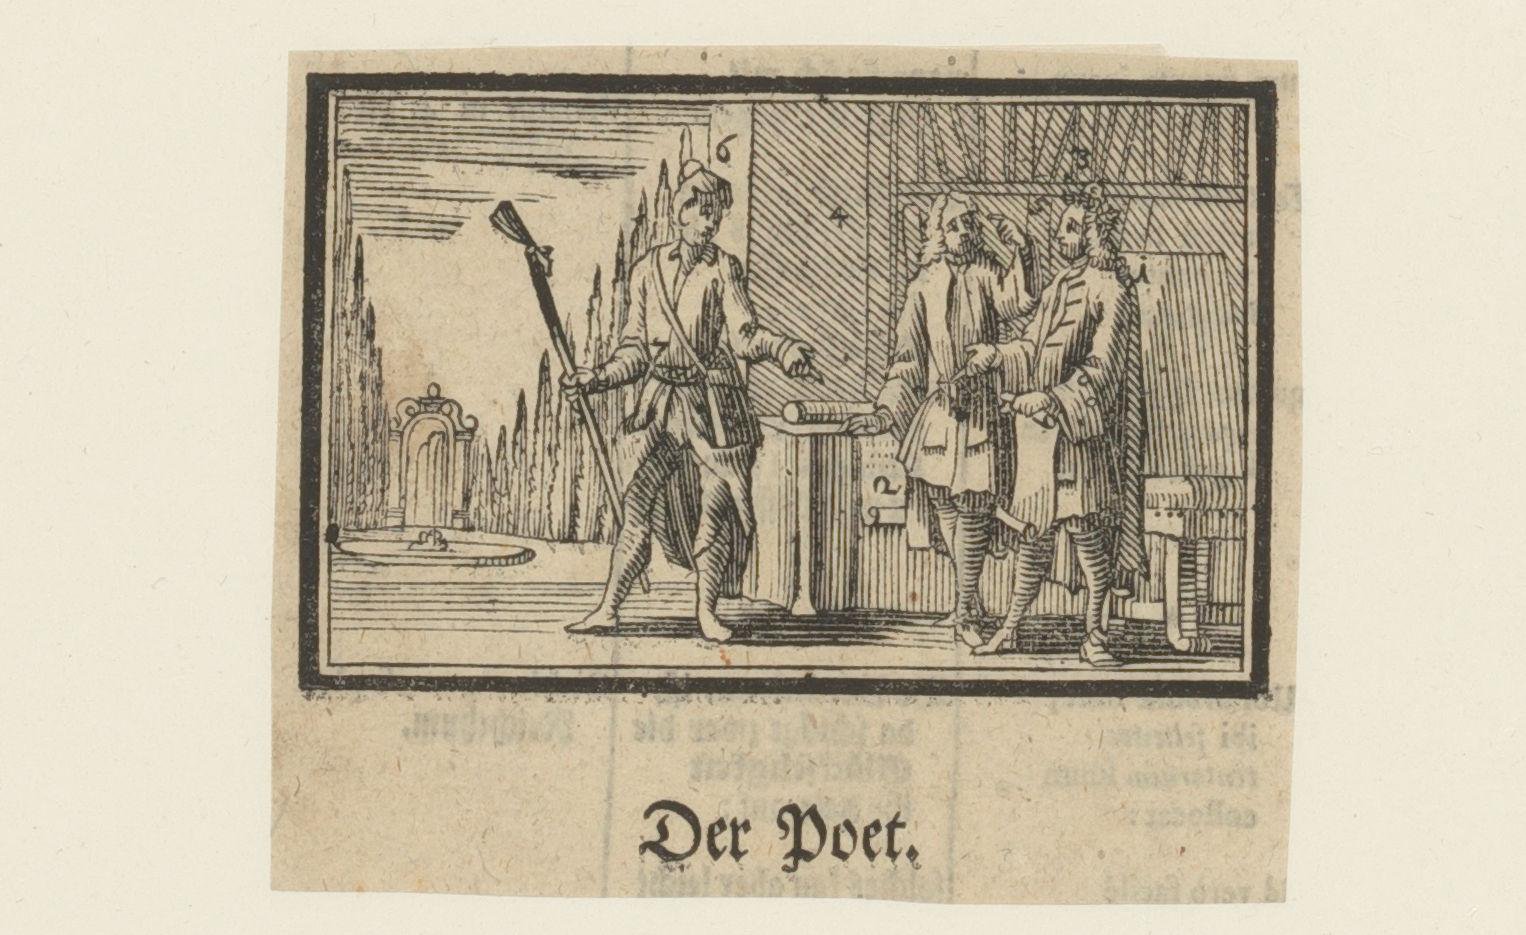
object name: print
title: Der Poet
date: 1719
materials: paper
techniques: letterpress printing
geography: nuremberg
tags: author, poet dictating, handicrafts, craftsman at work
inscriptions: collector's mark: Lugt 1641, stamp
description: Dichte met een tafeltje waar zijn gelegenheidsgedicht op ligt. De dichter is herkenbaar aan zijn kleding. Aan zijn gordel hangt een tas met boeken, papier en inkt. Onderwerpsrubrieken binnen de Atlas Zeden en Gewoonten: Handel, Nijverheid en Verkeer, Beroep en bedrijf, Complete suites.